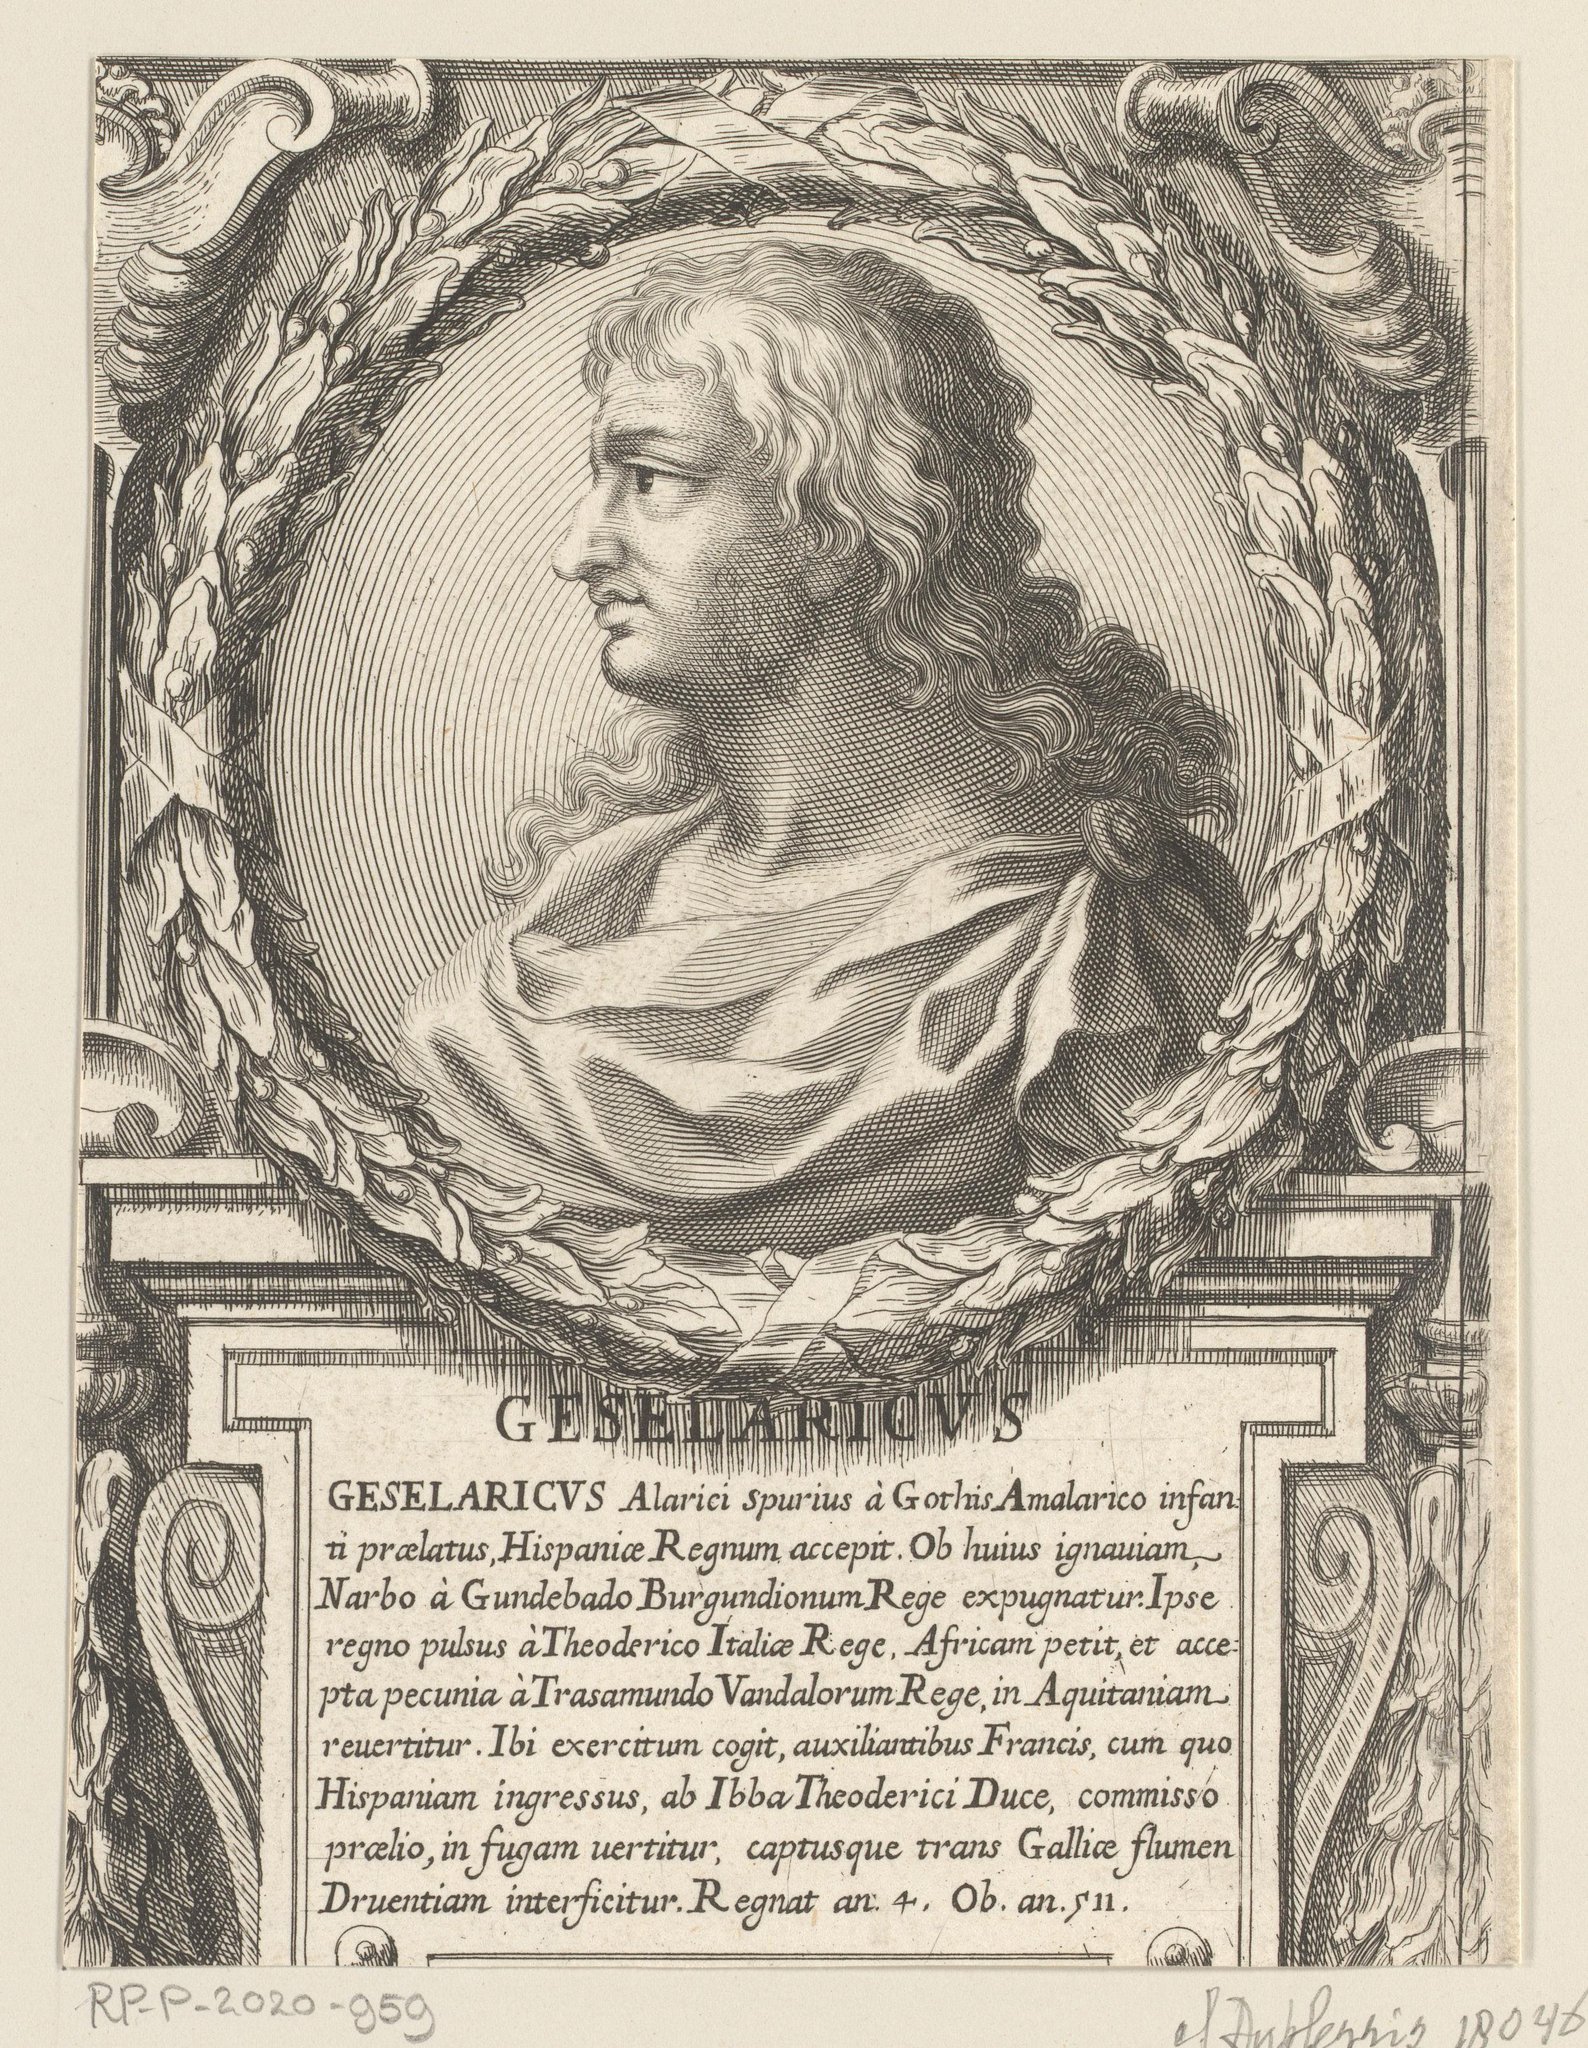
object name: print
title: Portret van Gesalec, koning van de Visigoten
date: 1685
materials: paper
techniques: engraving, etching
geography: rome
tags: historical persons, ruler, sovereign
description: Portret afkomstig van een grote prent, getiteld 'Series Chronologica et Imagines Regu Hispaniae ab Ataulpho ad Carolum II', bestaande uit tien bladen die samengevoegd konden worden, uitgegeven door Giovanni Giacomo de' Rossi in 1685.